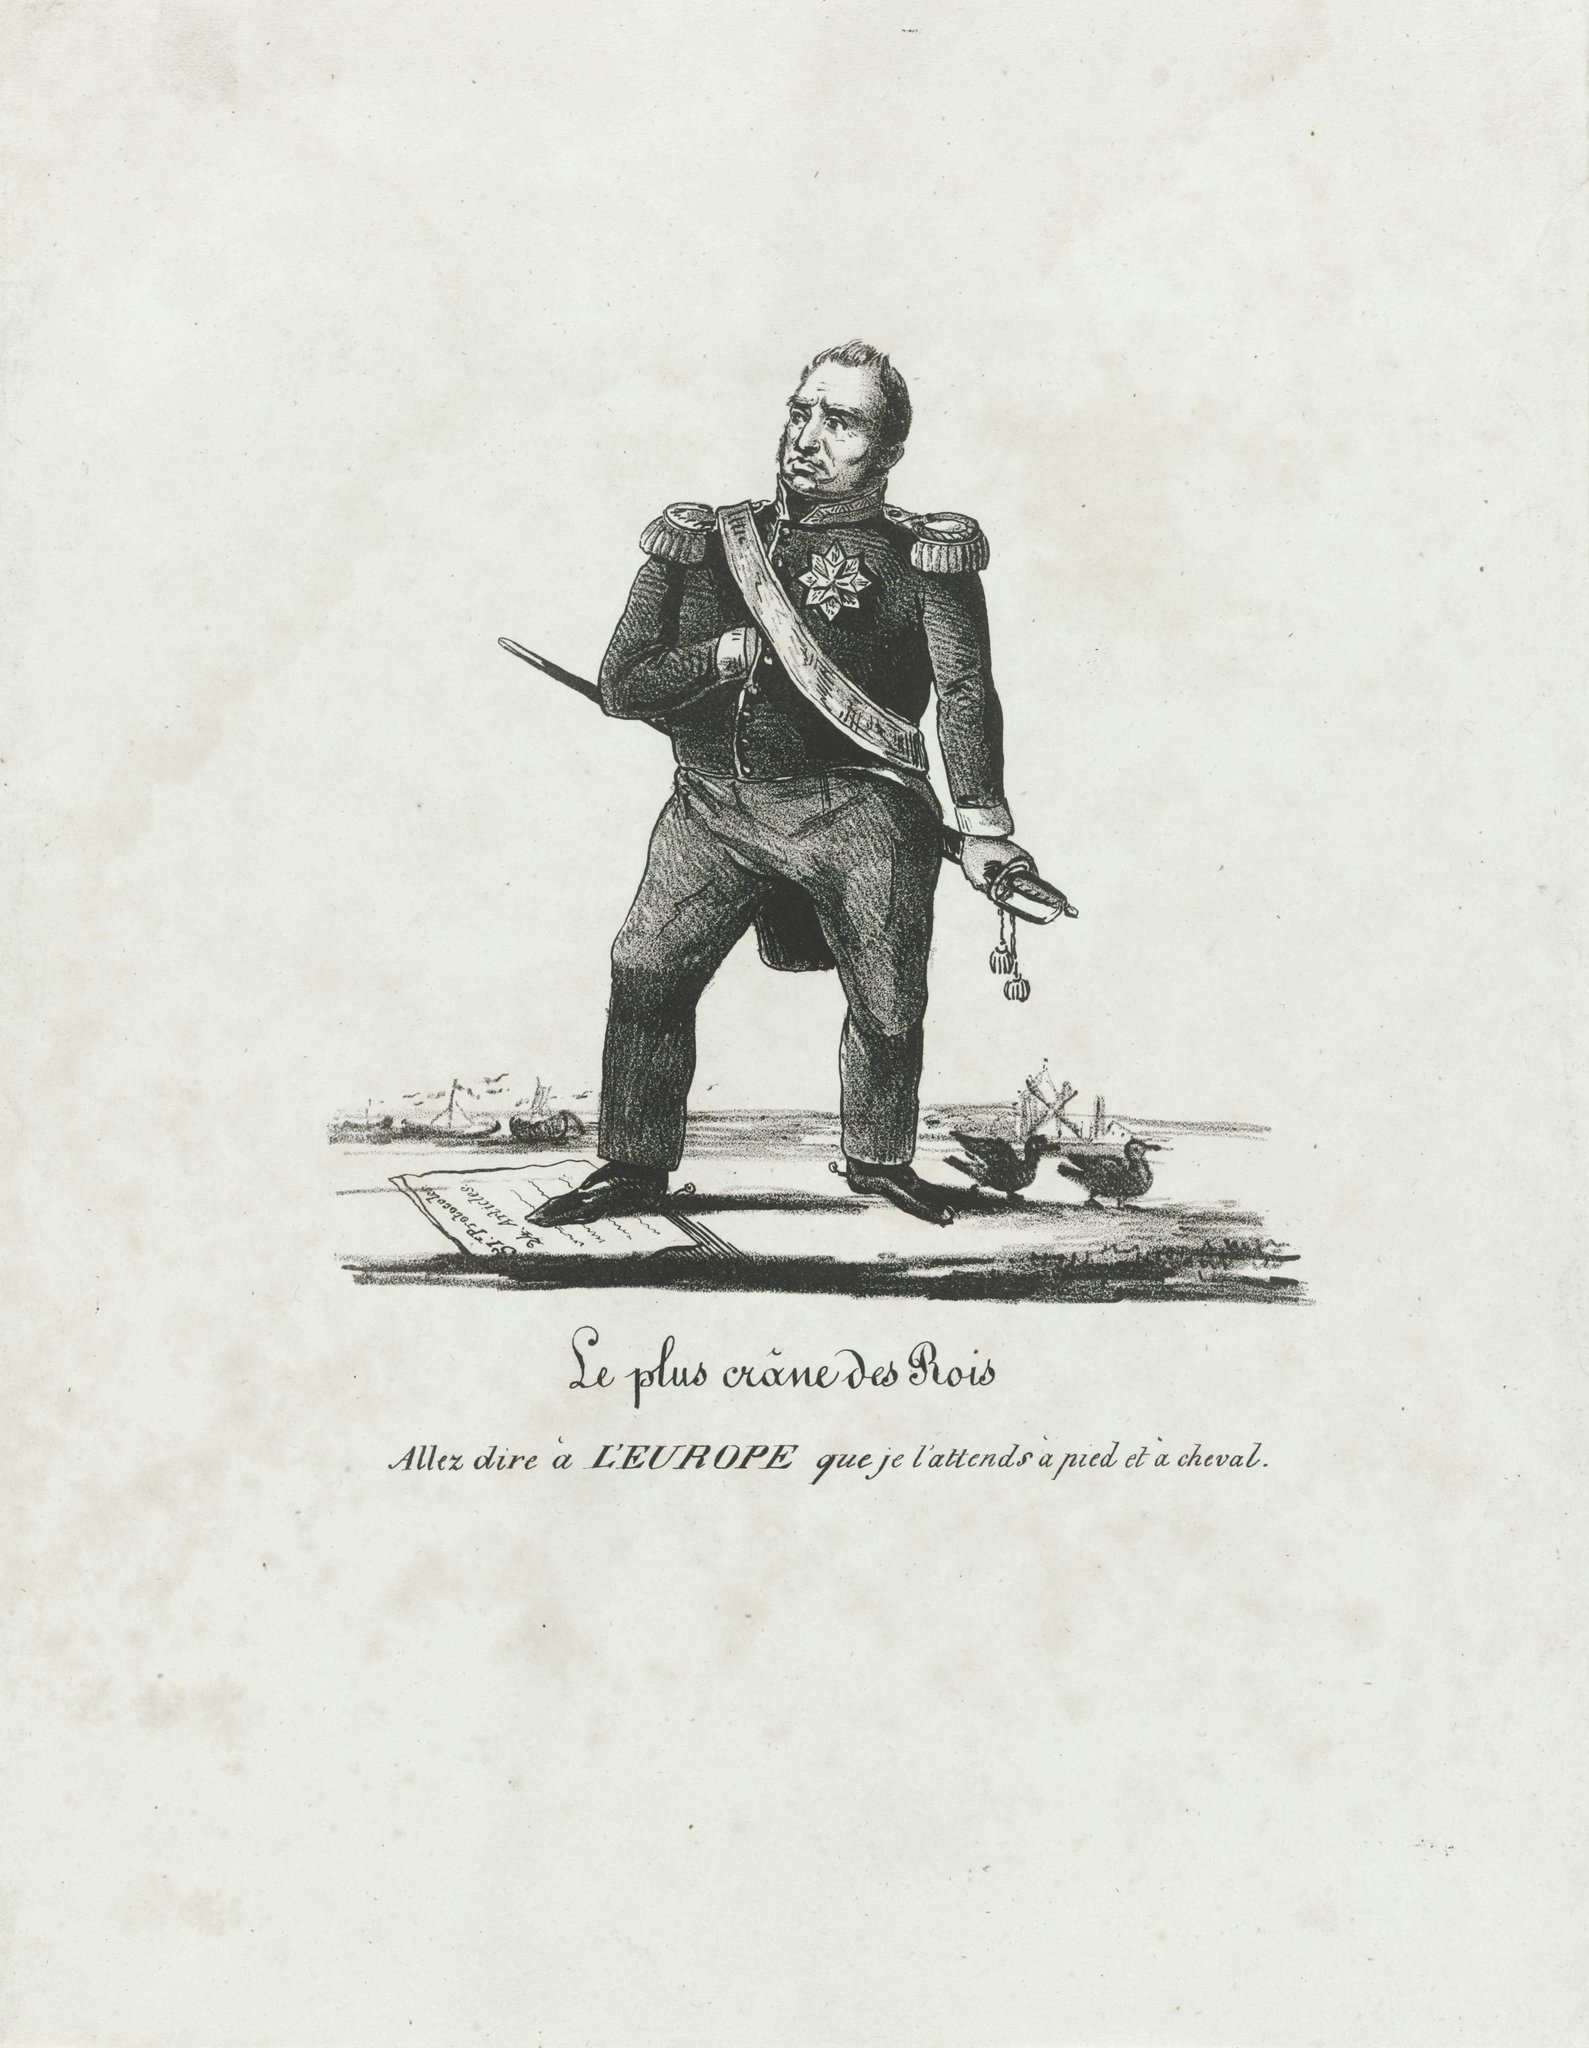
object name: print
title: De kranigste koning, 1831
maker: Anonymous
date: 1831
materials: paper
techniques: lithograph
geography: belgium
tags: the hague, berlin, william i of the netherlands, trampling, treading, stamping on someone or something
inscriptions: collector's mark: Lugt 2228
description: Spotprent op koning Willem I na het verwerpen van het verdrag der XXIV artikelen van de Londense Conferentie, 13 oktober 1831. De koning vertreedt onder de voet het document van de 24 artikelen.